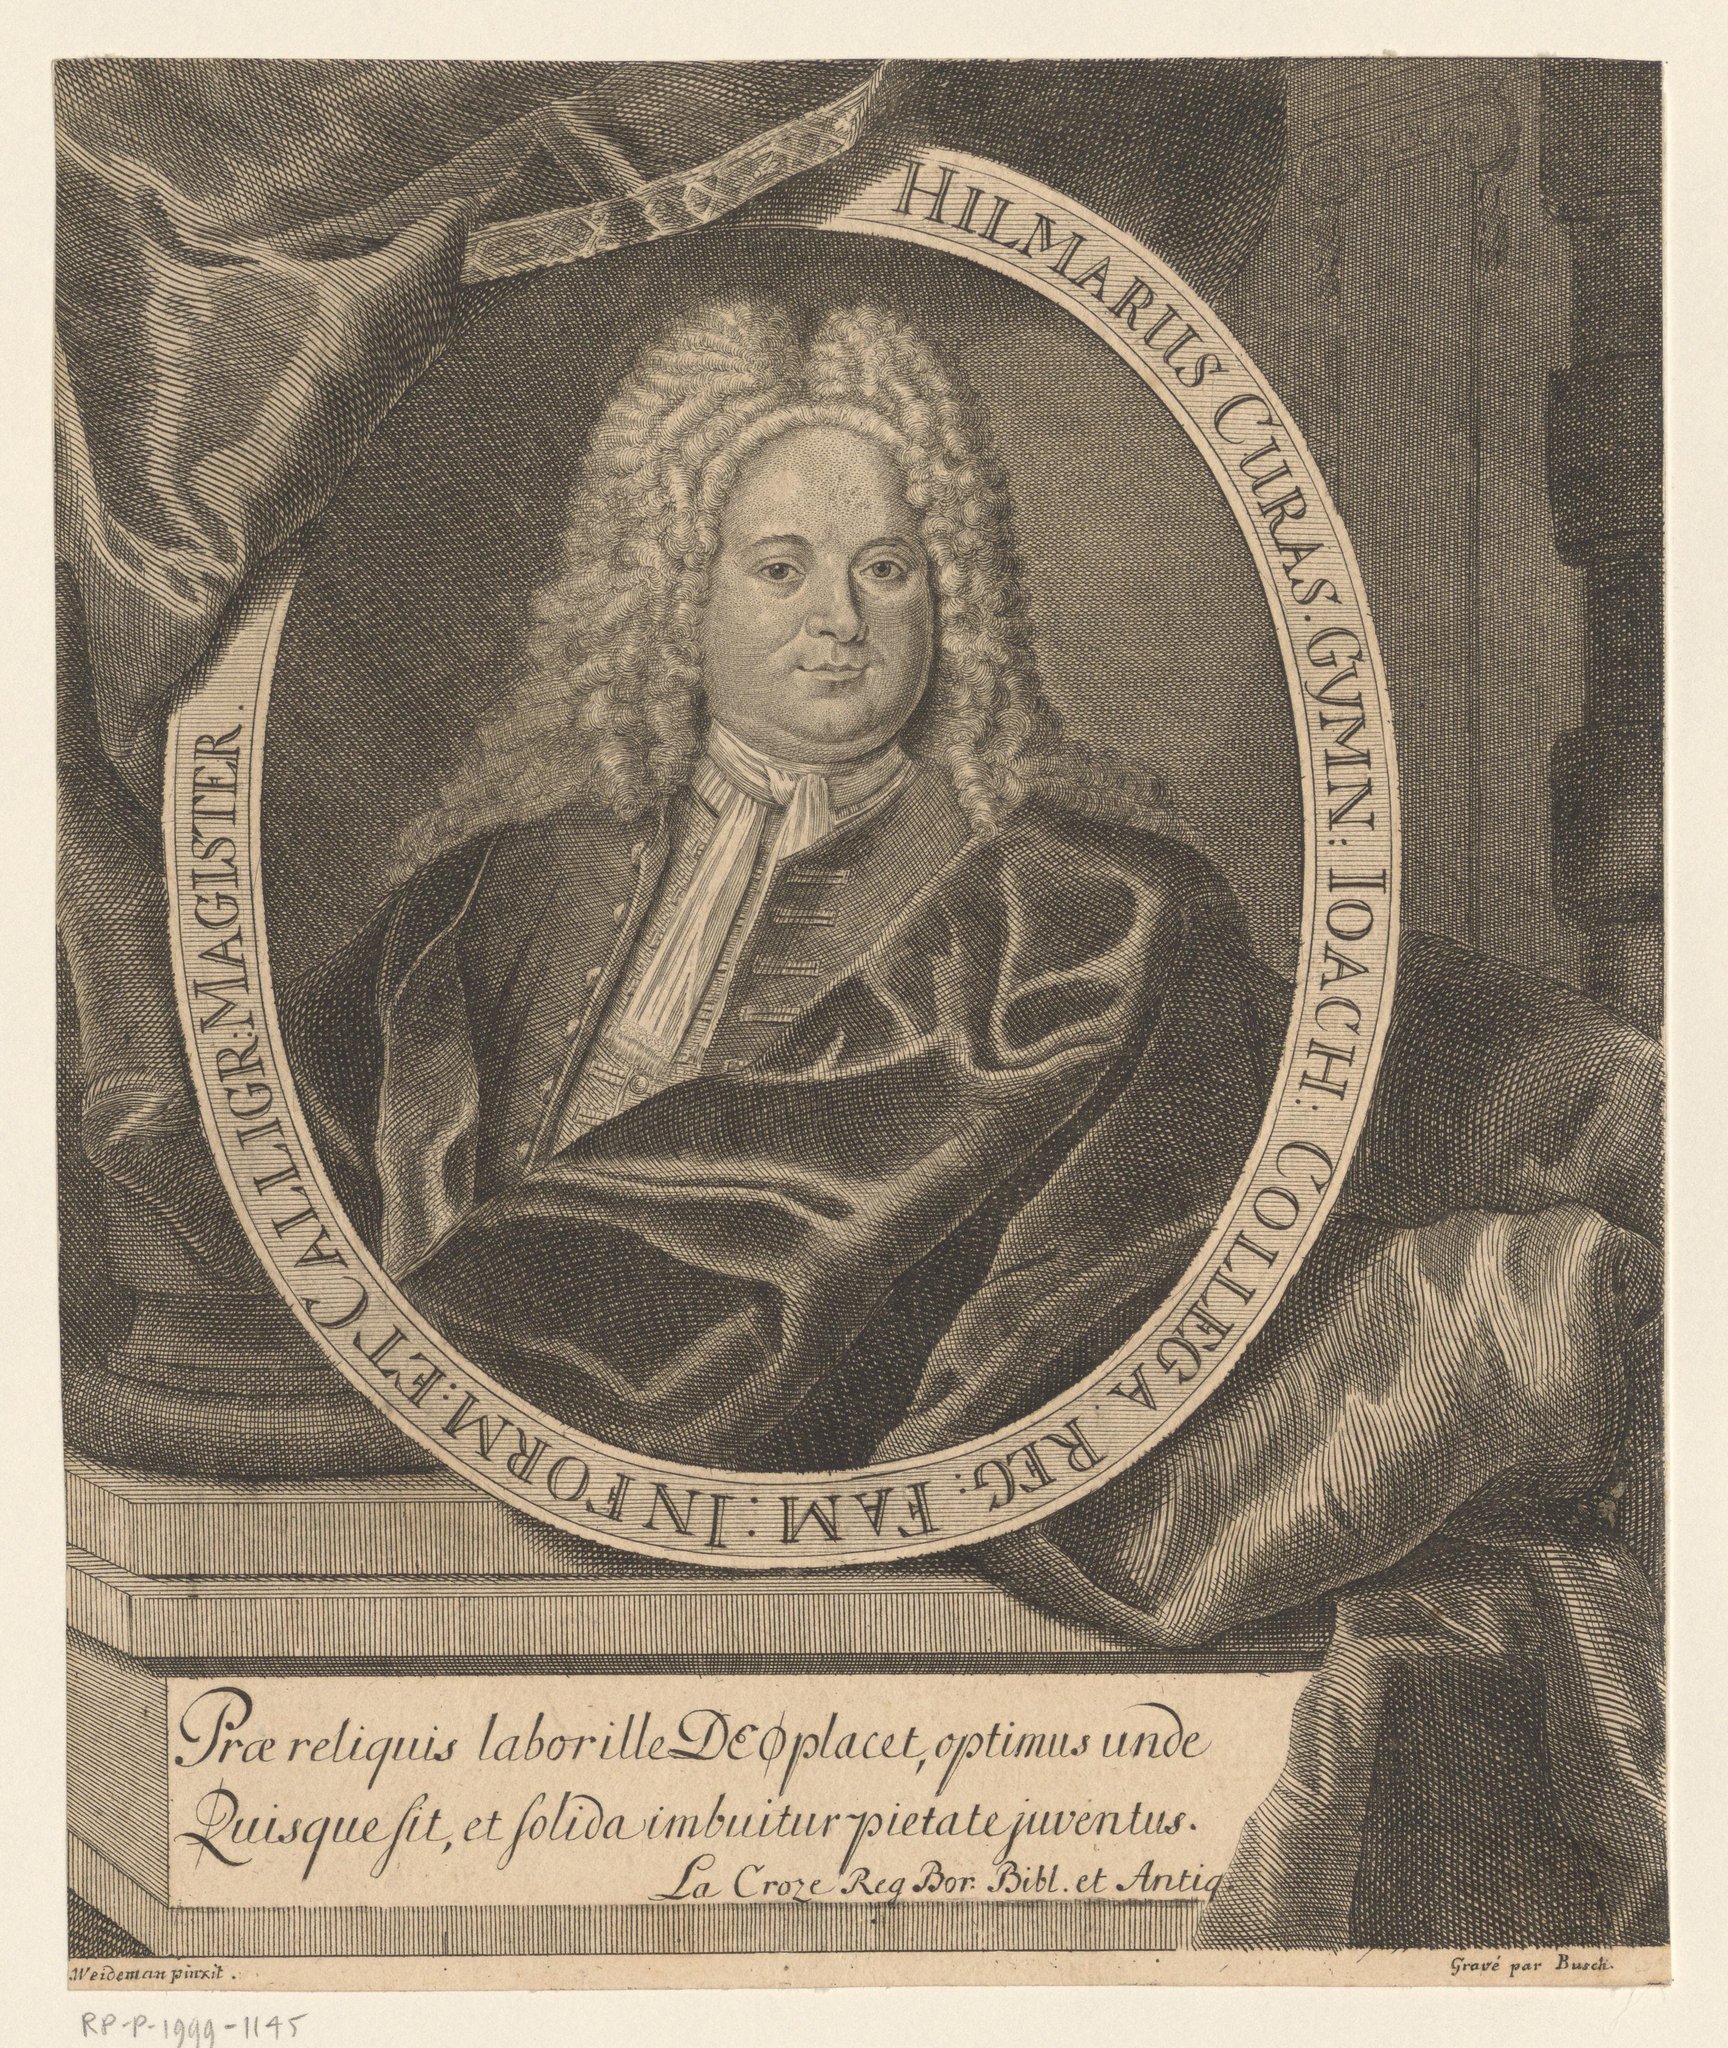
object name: print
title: Portret van Hilmar Curas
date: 1716-1756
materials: paper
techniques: engraving, etching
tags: historical persons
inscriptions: collector's mark: Lugt 2228